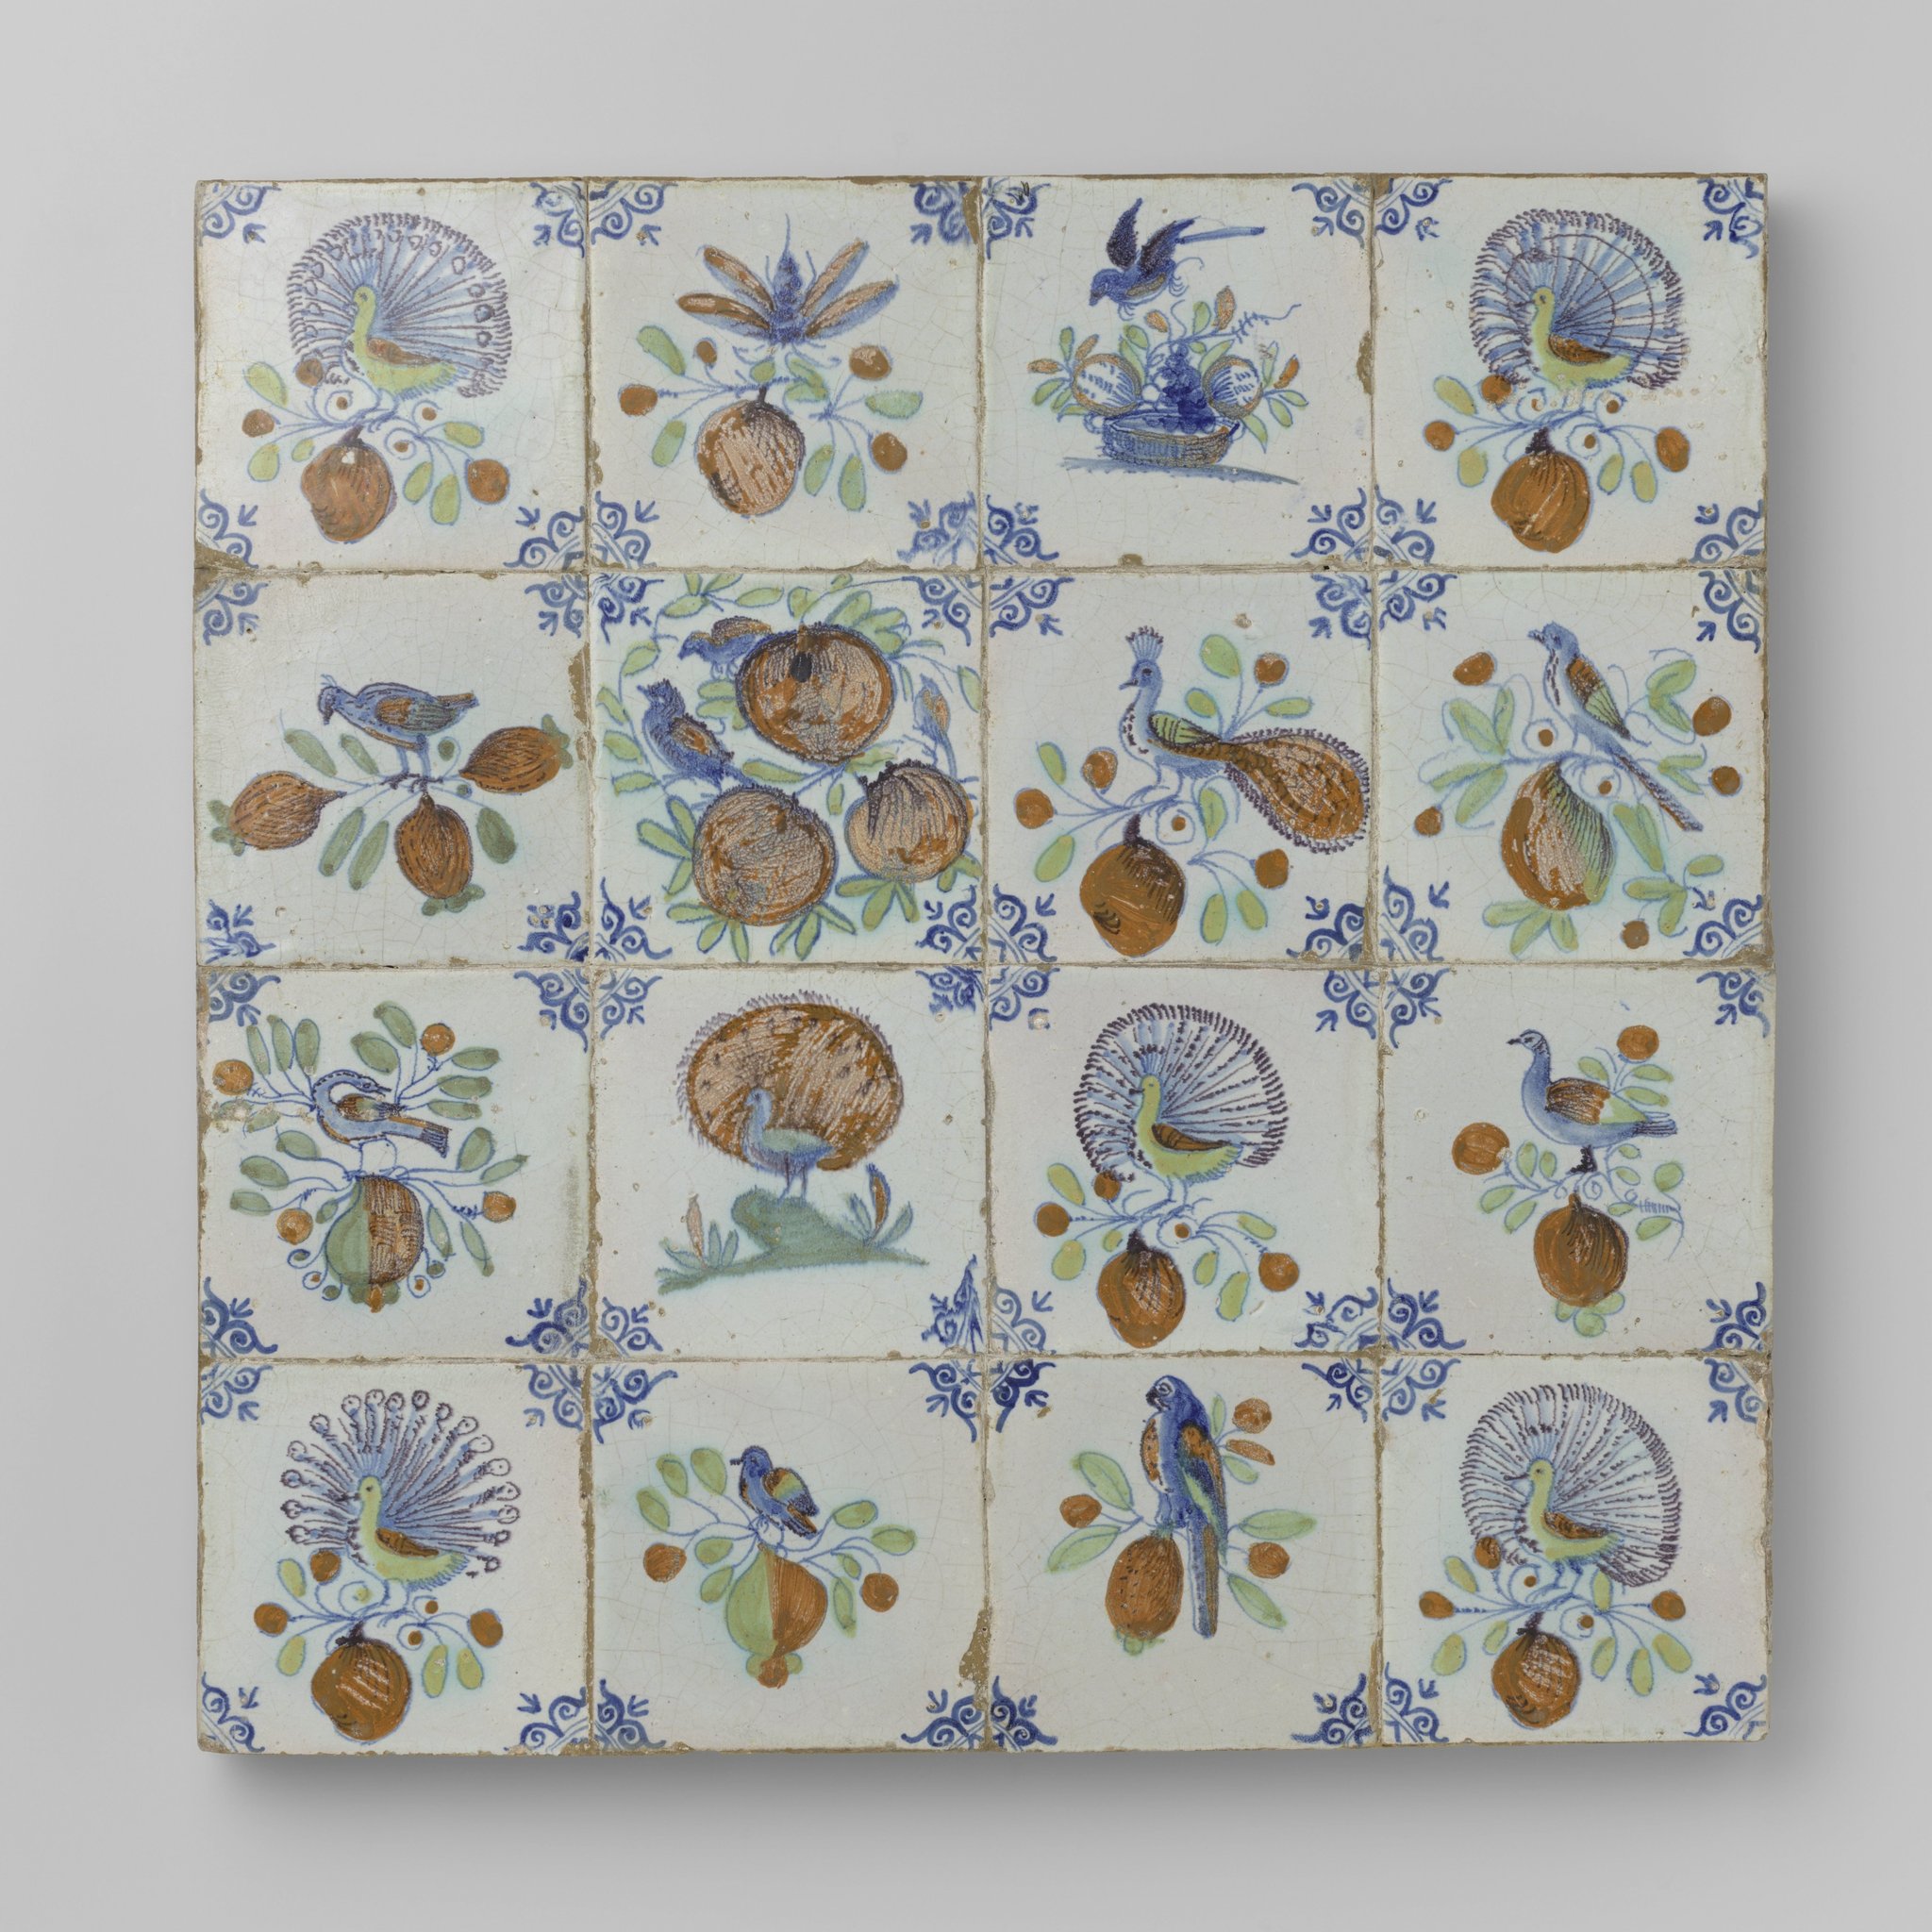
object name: tegelveld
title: Veld van zestien tegels met vogels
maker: Anonymous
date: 1640-1660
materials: earthenware, glaze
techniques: maiolica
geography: netherlands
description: Veld van zestien tegels (4 x 4) elk met een veelkleurige (blauw, groen, geel, oranje en paars) vogel waaronder 7 pauwen op een takje met besjes. In de hoeken, een ossenkop.